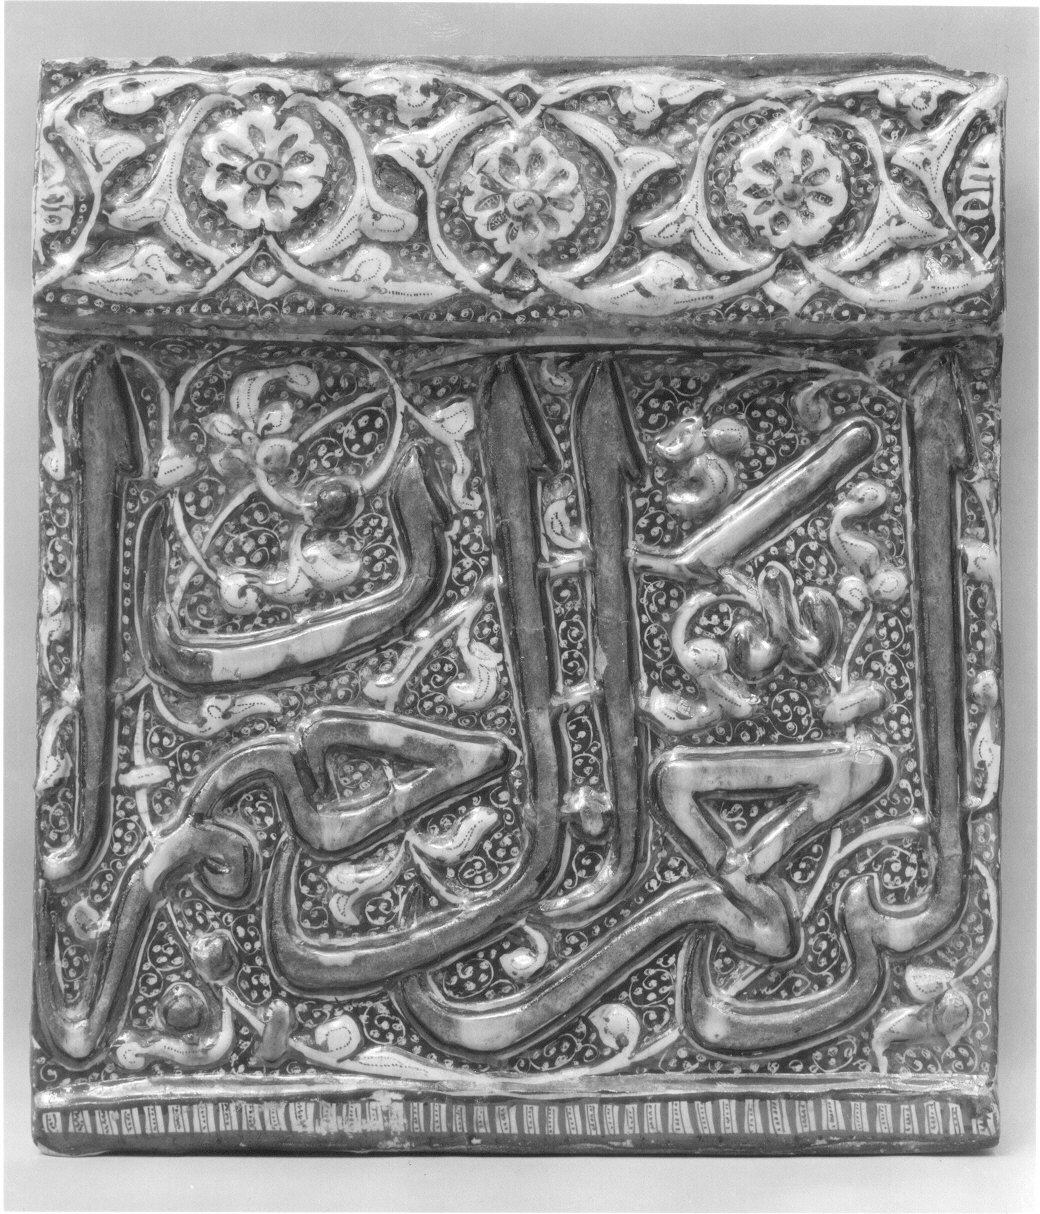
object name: tile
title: Tile from a Frieze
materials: stonepaste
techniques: glazing, luster painting, molding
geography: iran